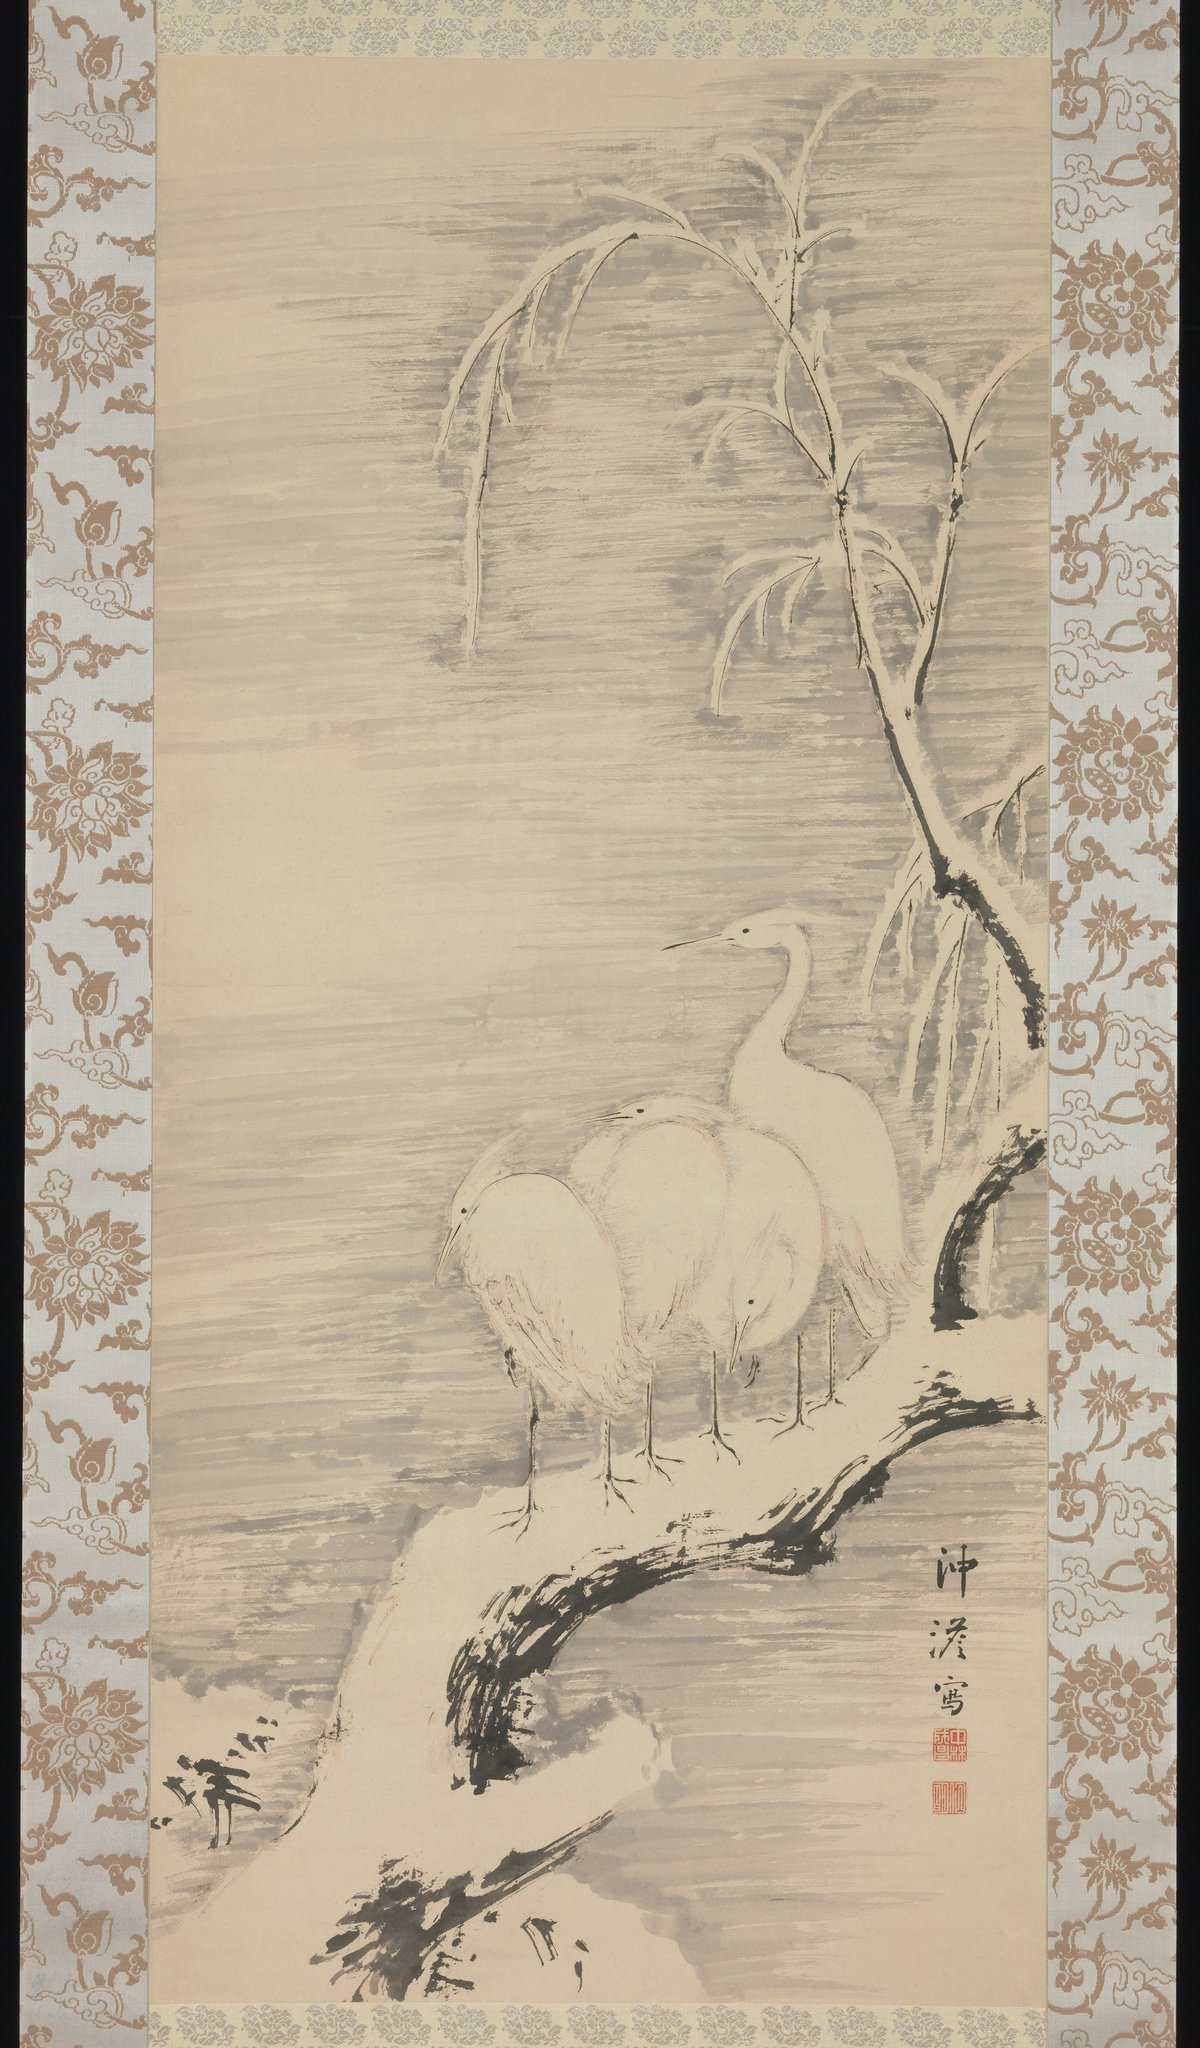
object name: hanging scroll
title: Herons in the Snow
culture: japanese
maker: nakabayashi chikutō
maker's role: artist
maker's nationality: japanese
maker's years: 1776-1853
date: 1840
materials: ink, paper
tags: birds,trees,snow